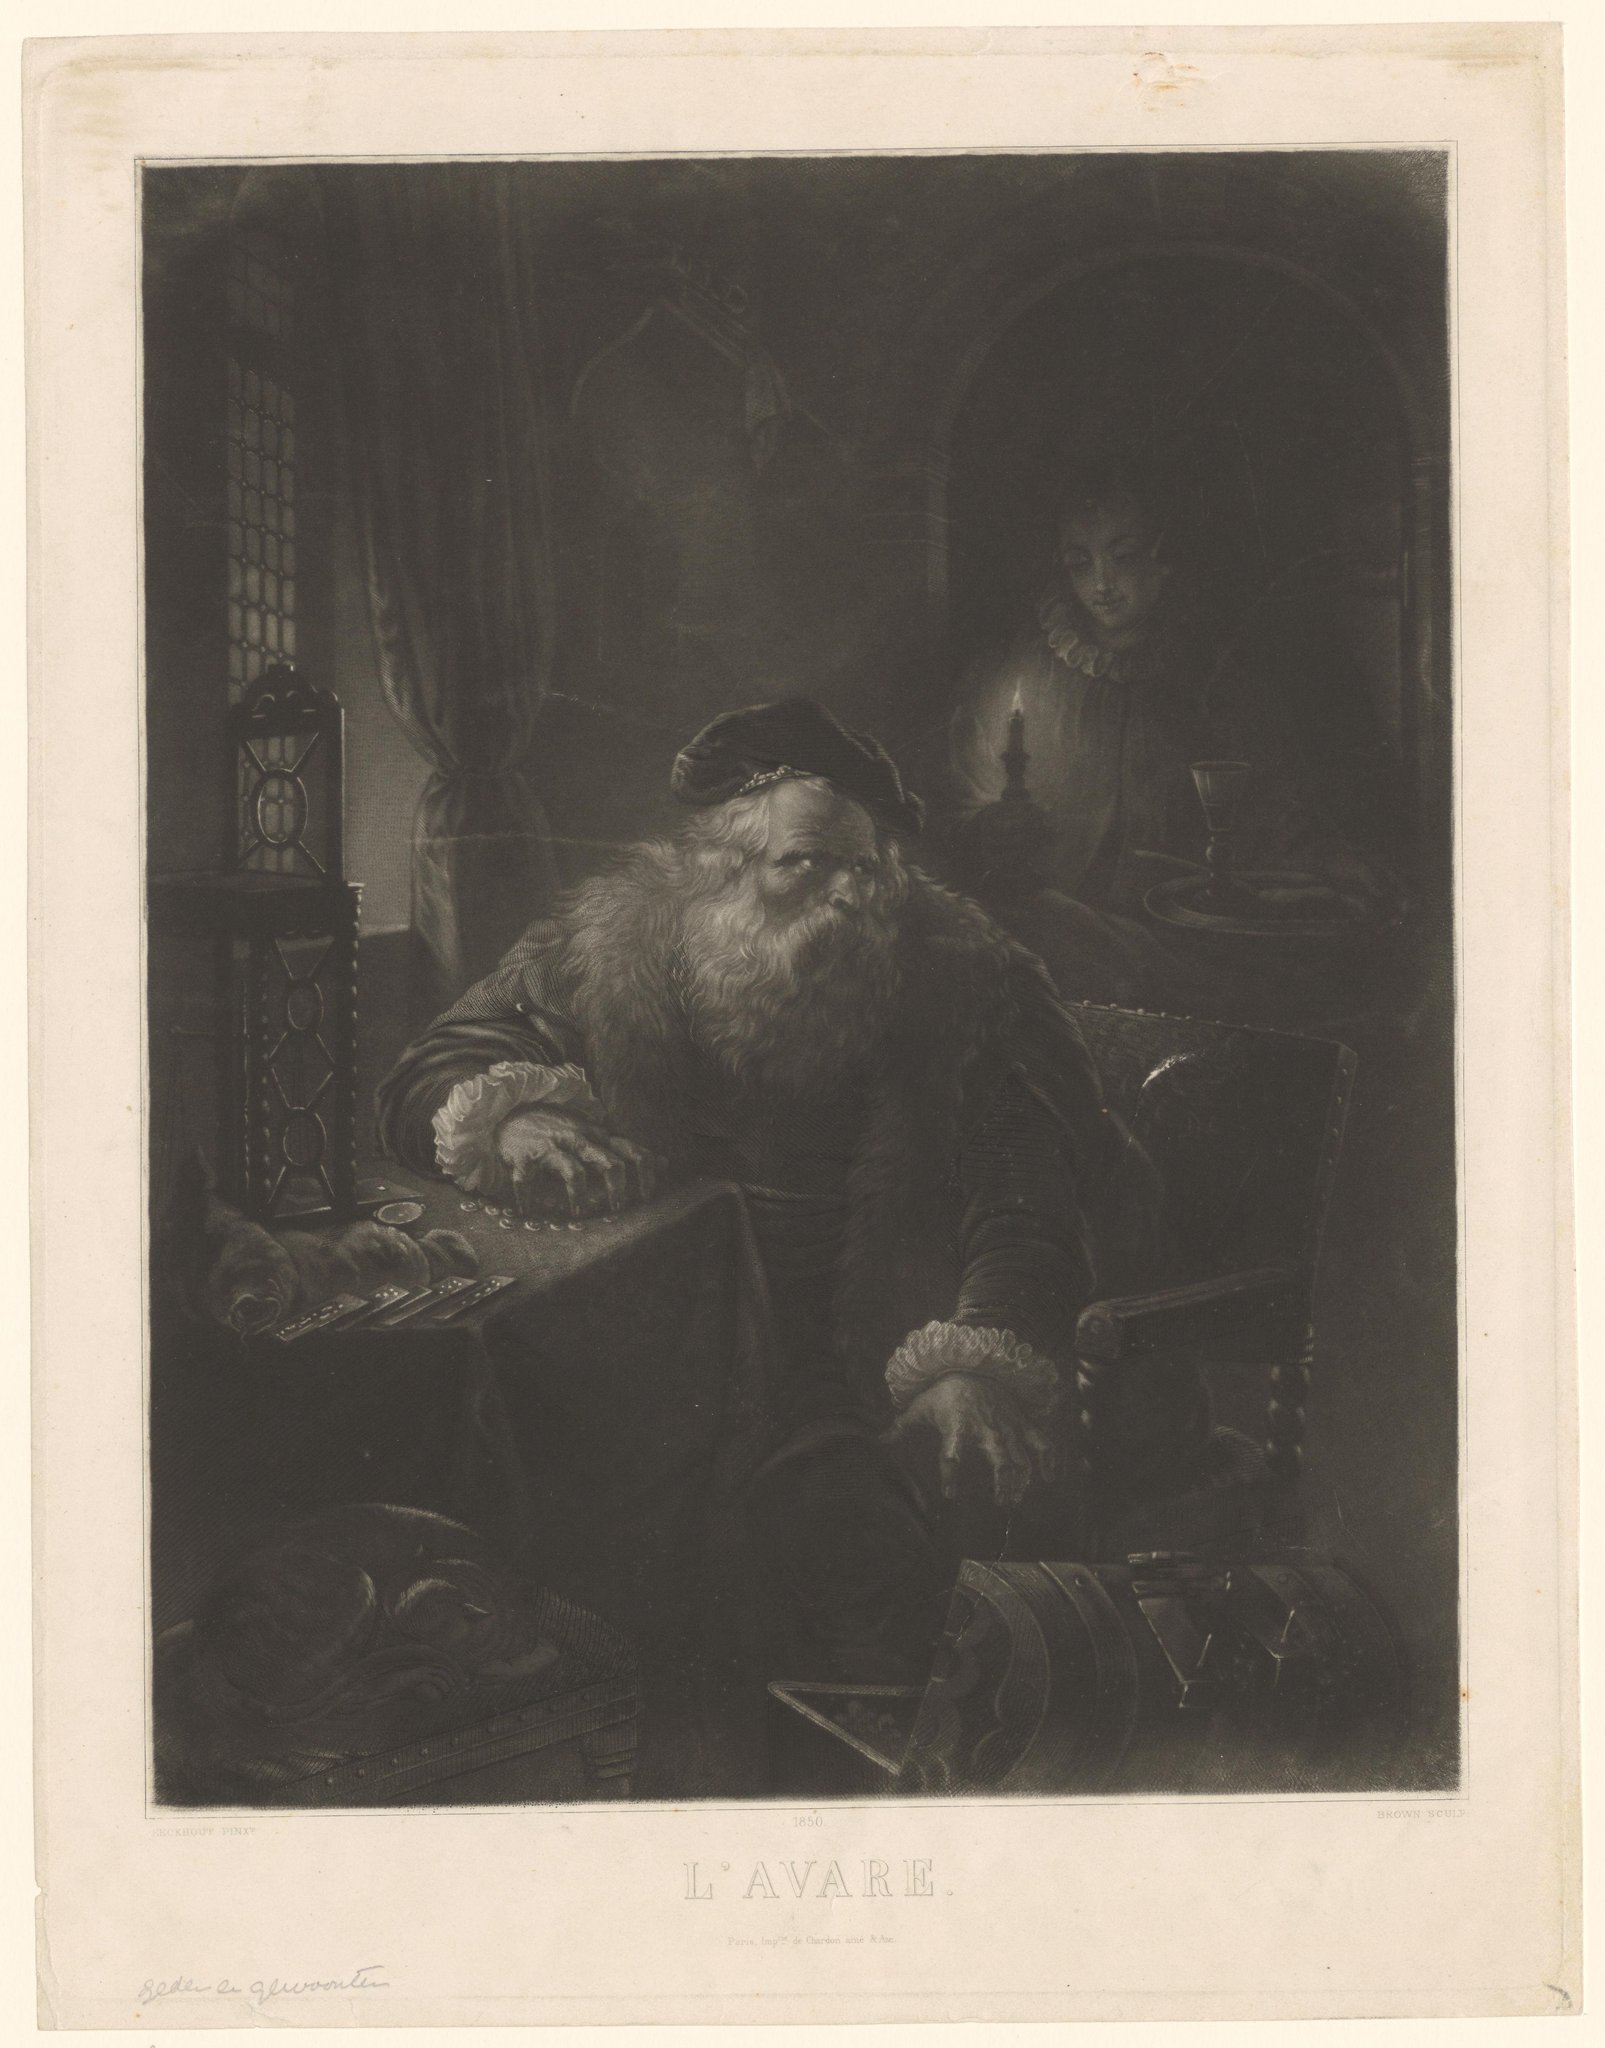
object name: print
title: Man zit aan een bureau en legt zijn hand op muntstukken terwijl er een bediende binnenkomt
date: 1850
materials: paper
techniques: engraving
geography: paris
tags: covetousness; 'avaritia' (ripa) ~ personification of one of the seven deadly sins, greed, covetousness, cupidity; 'cupidità' (ripa), miser, money-chest, treasure-chest, money-box, house personnel, servants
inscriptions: collector's mark: Lugt 2228